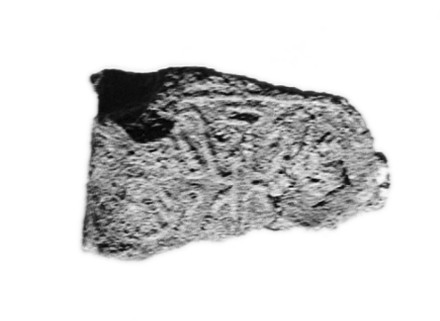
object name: sealing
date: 1981-1640 BCE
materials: mud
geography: egypt